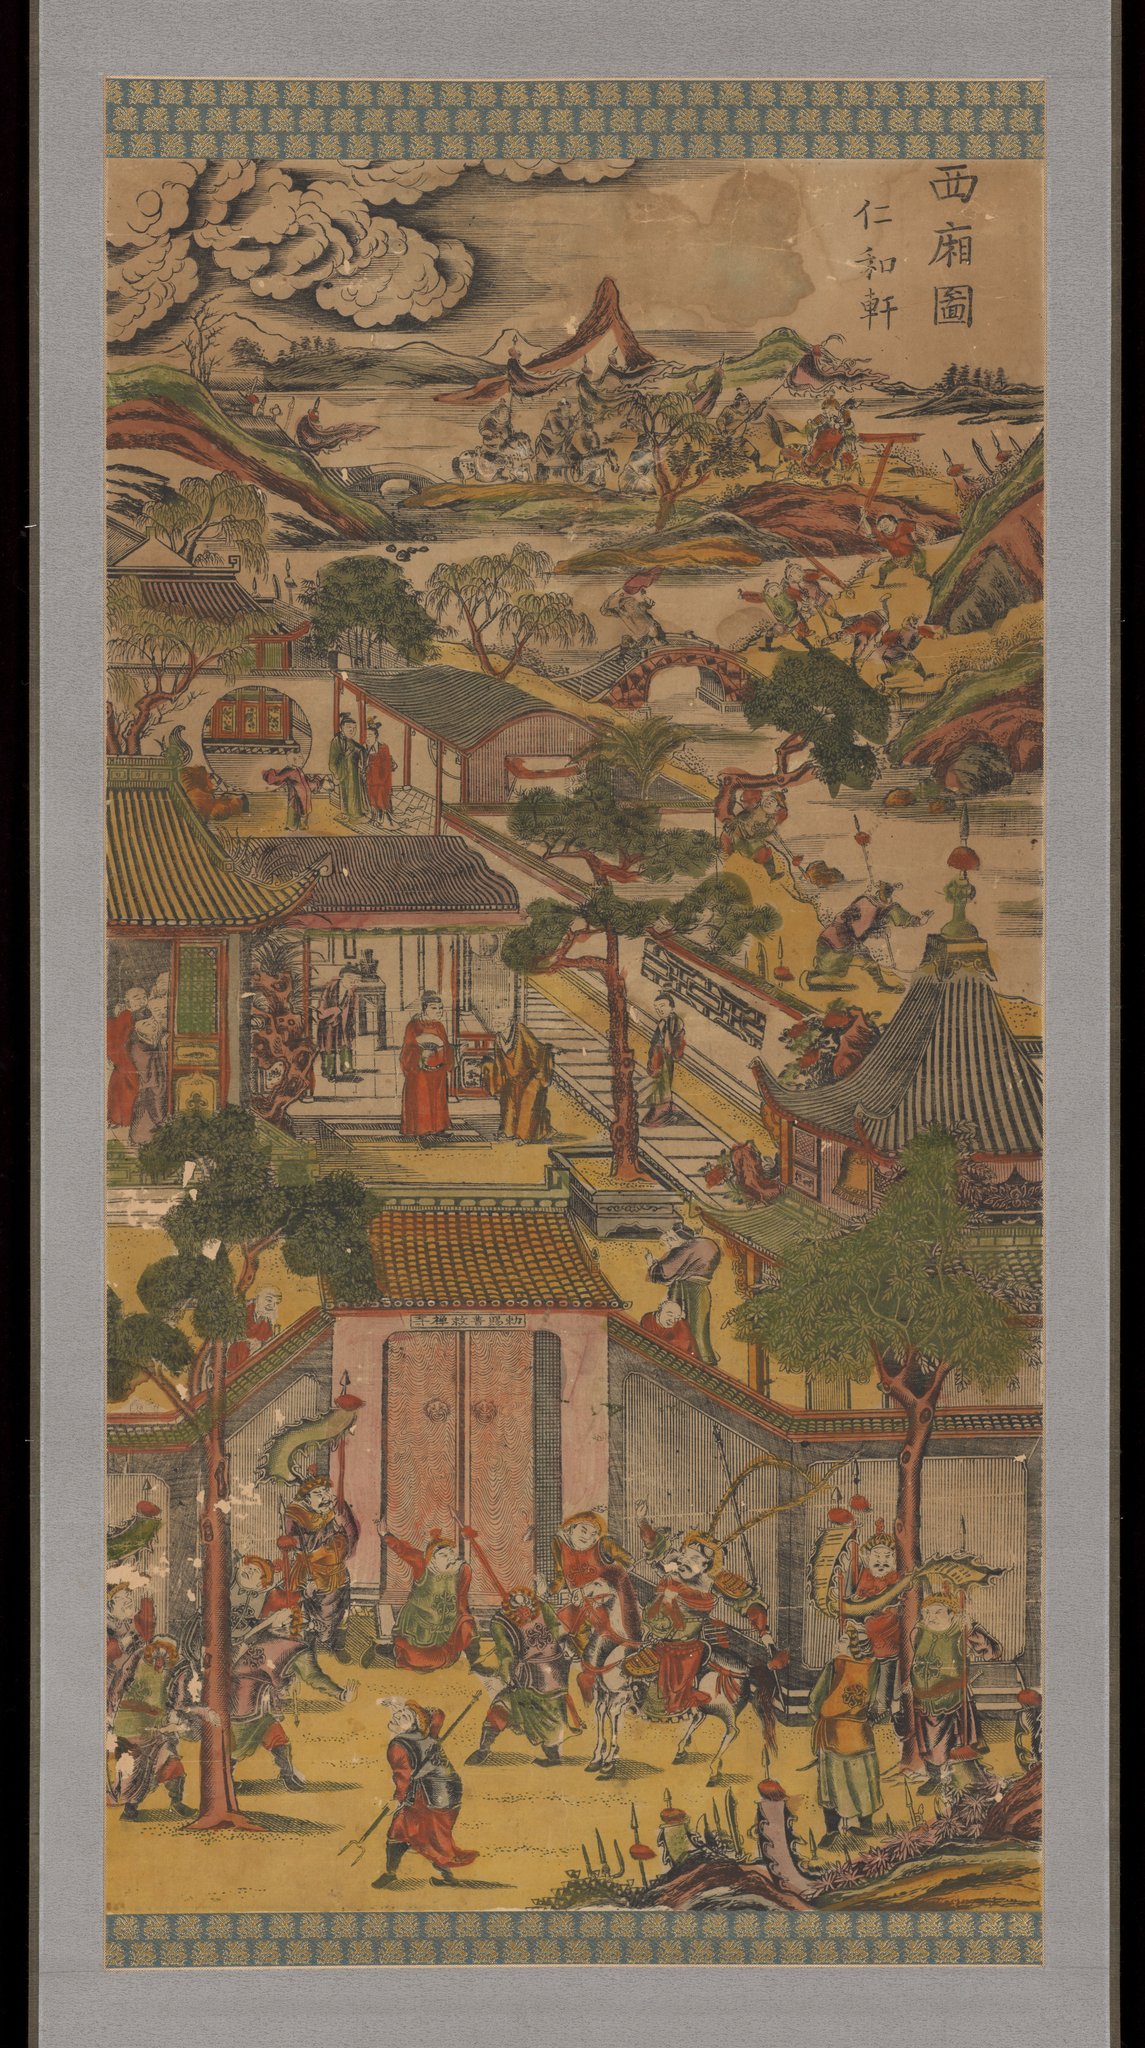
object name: print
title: Story of the Western Chamber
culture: chinese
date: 1736-1795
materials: ink, paper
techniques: hand coloring, woodblock print